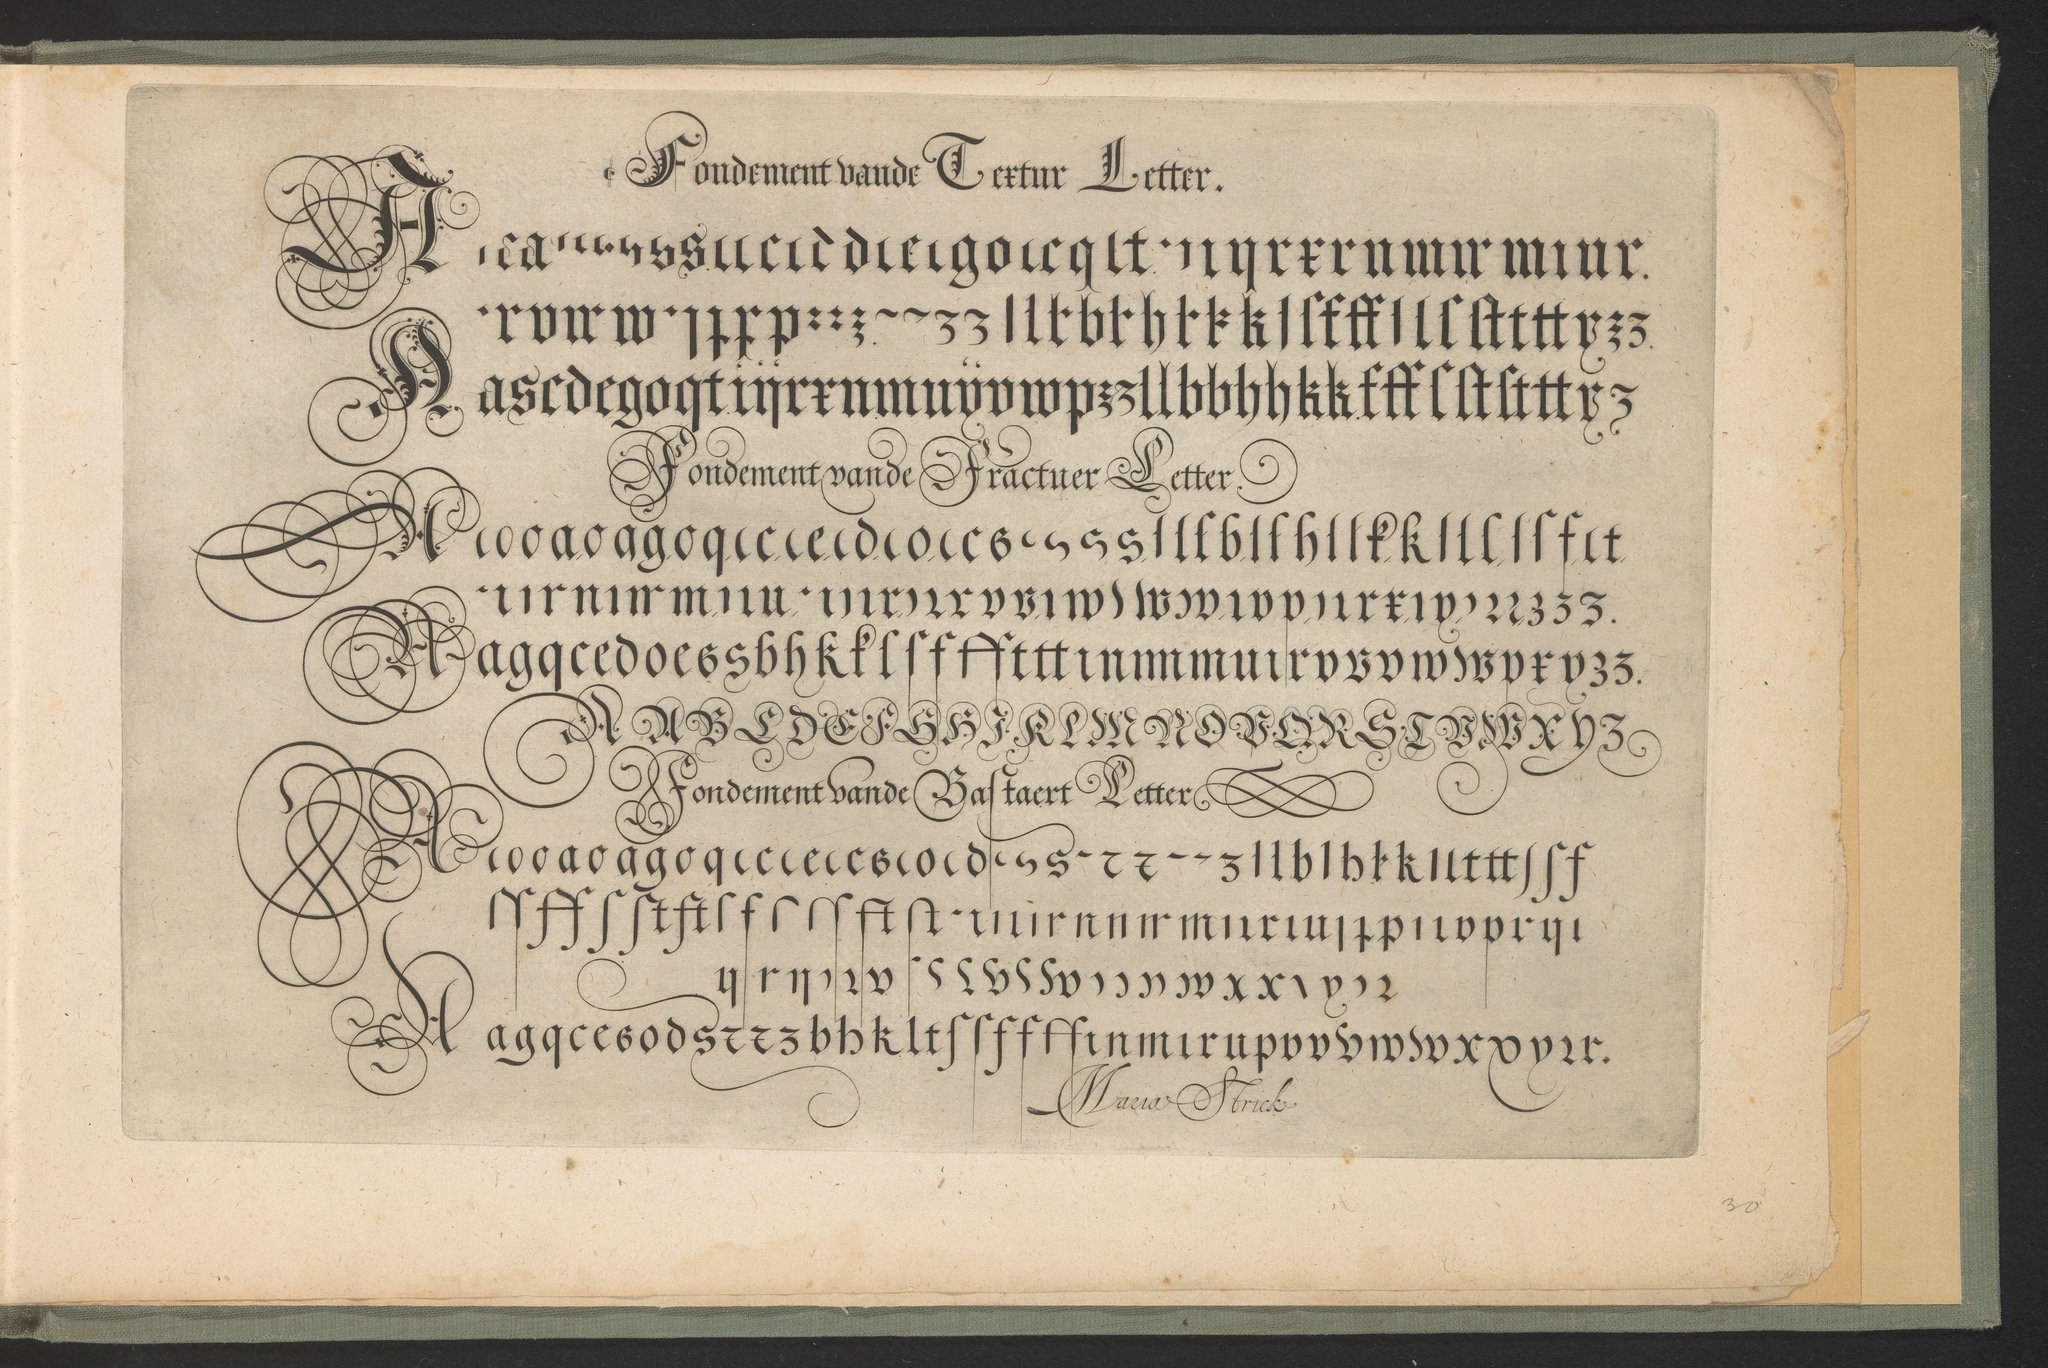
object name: print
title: Schat oft voorbeelt ende verthooninge van verscheyden geschriften (...)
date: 1618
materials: paper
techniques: engraving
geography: rotterdam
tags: calligraphy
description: Lettervoorbeelden van de textura, fraktur en bastarde, veertien regels. De prent maakt deel uit van een album.